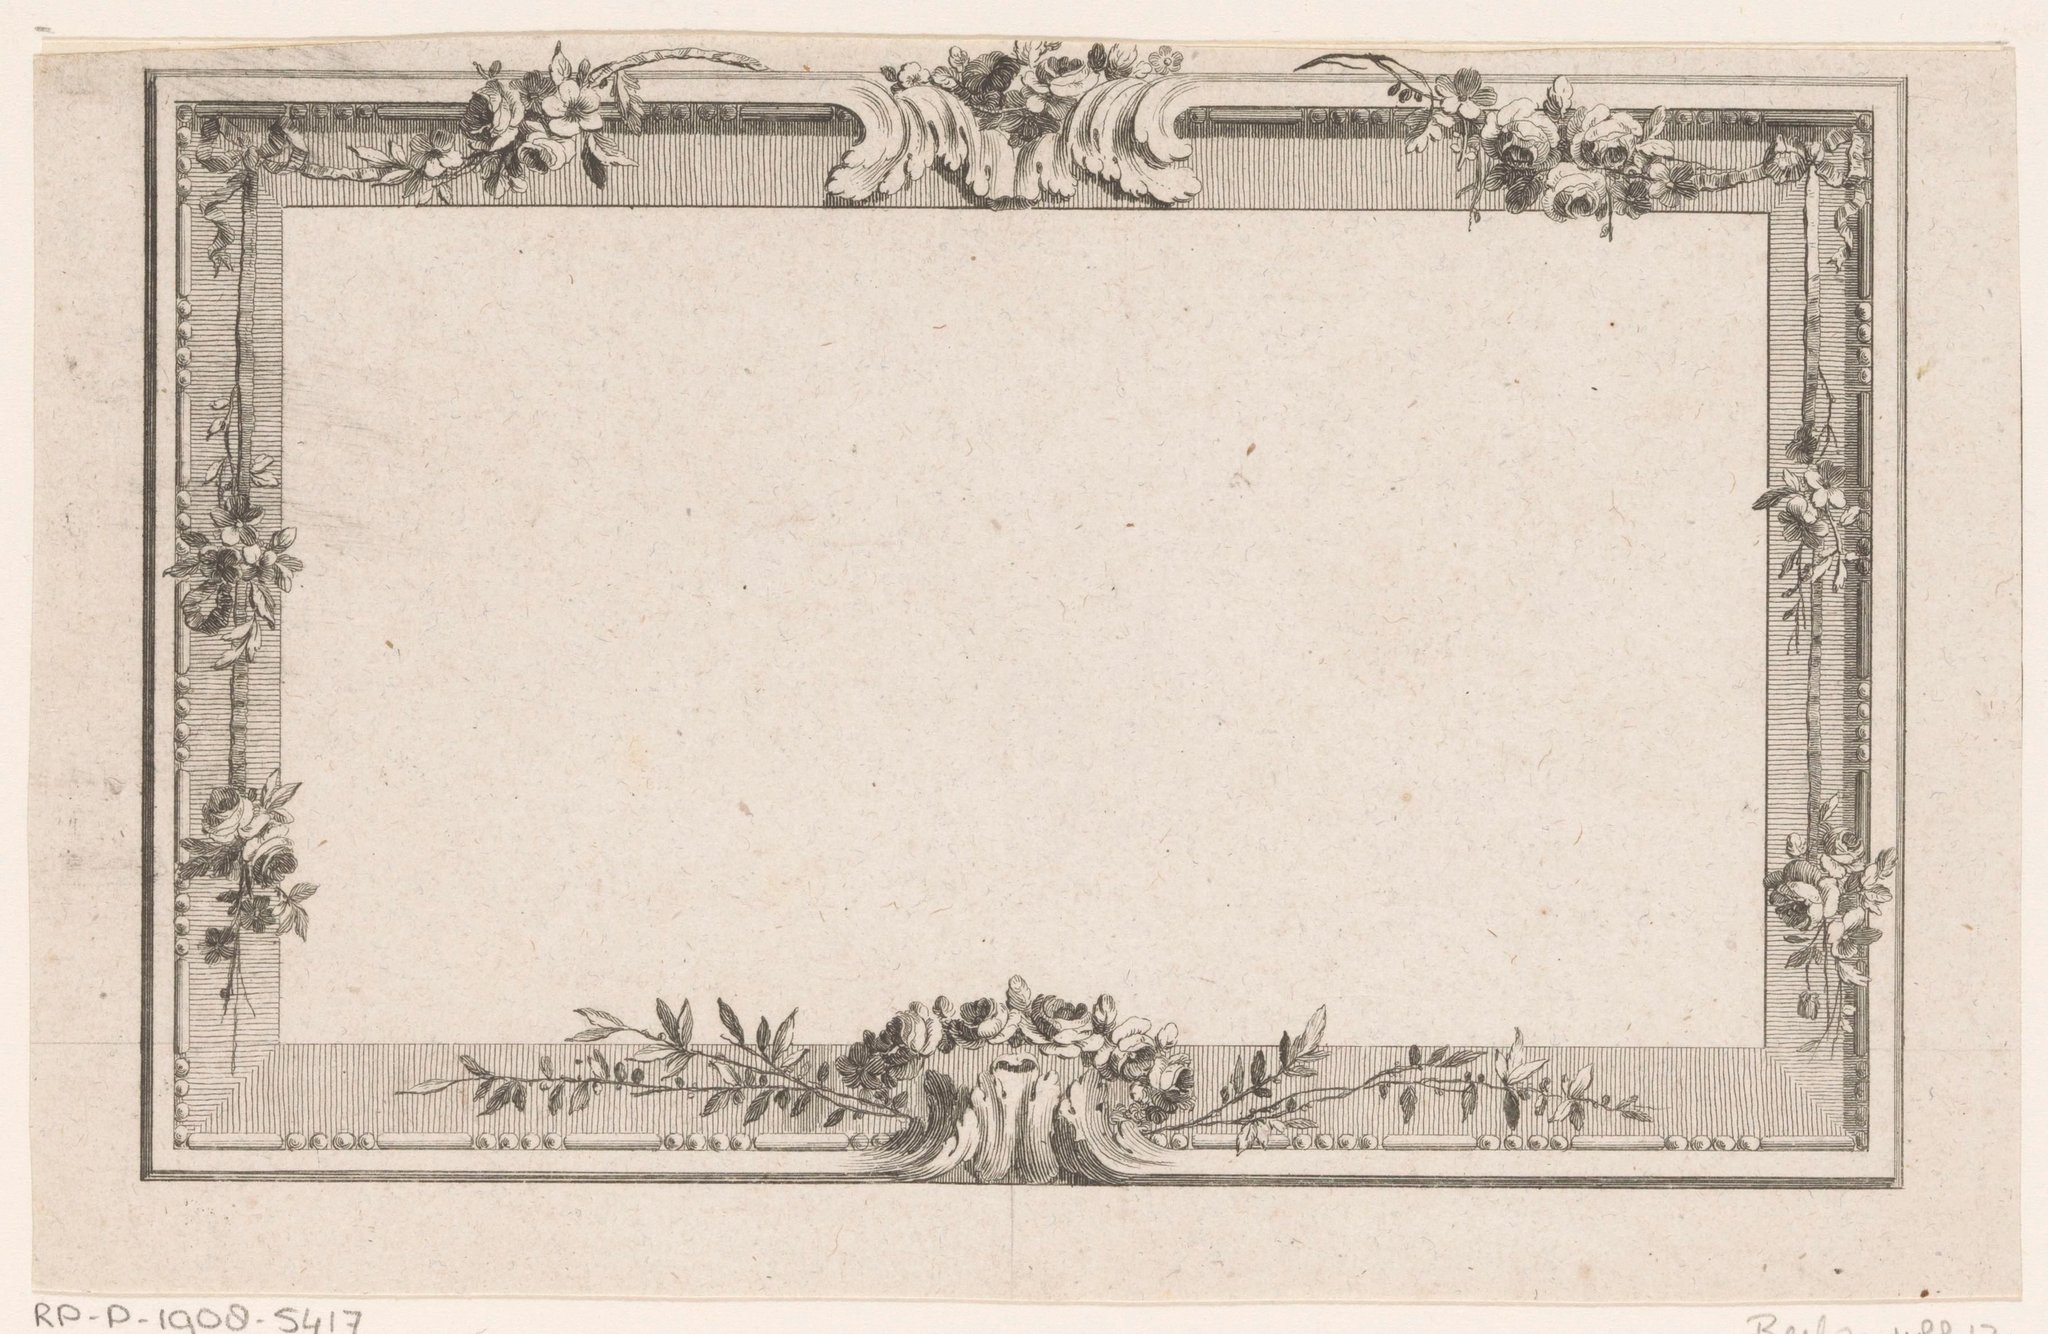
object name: print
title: 17e Cahier de Cartels et Trophées de l'Oeuvre de Ranson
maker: pierre gabriel berthault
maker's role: print maker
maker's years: 1737-1819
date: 1778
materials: paper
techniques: etching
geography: paris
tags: ornaments ~ art (+ framing decorations), flowers ~ ornament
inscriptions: collector's mark: Lugt 2228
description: Een rechthoekige omlijsting met bloemen en bladmotieven.